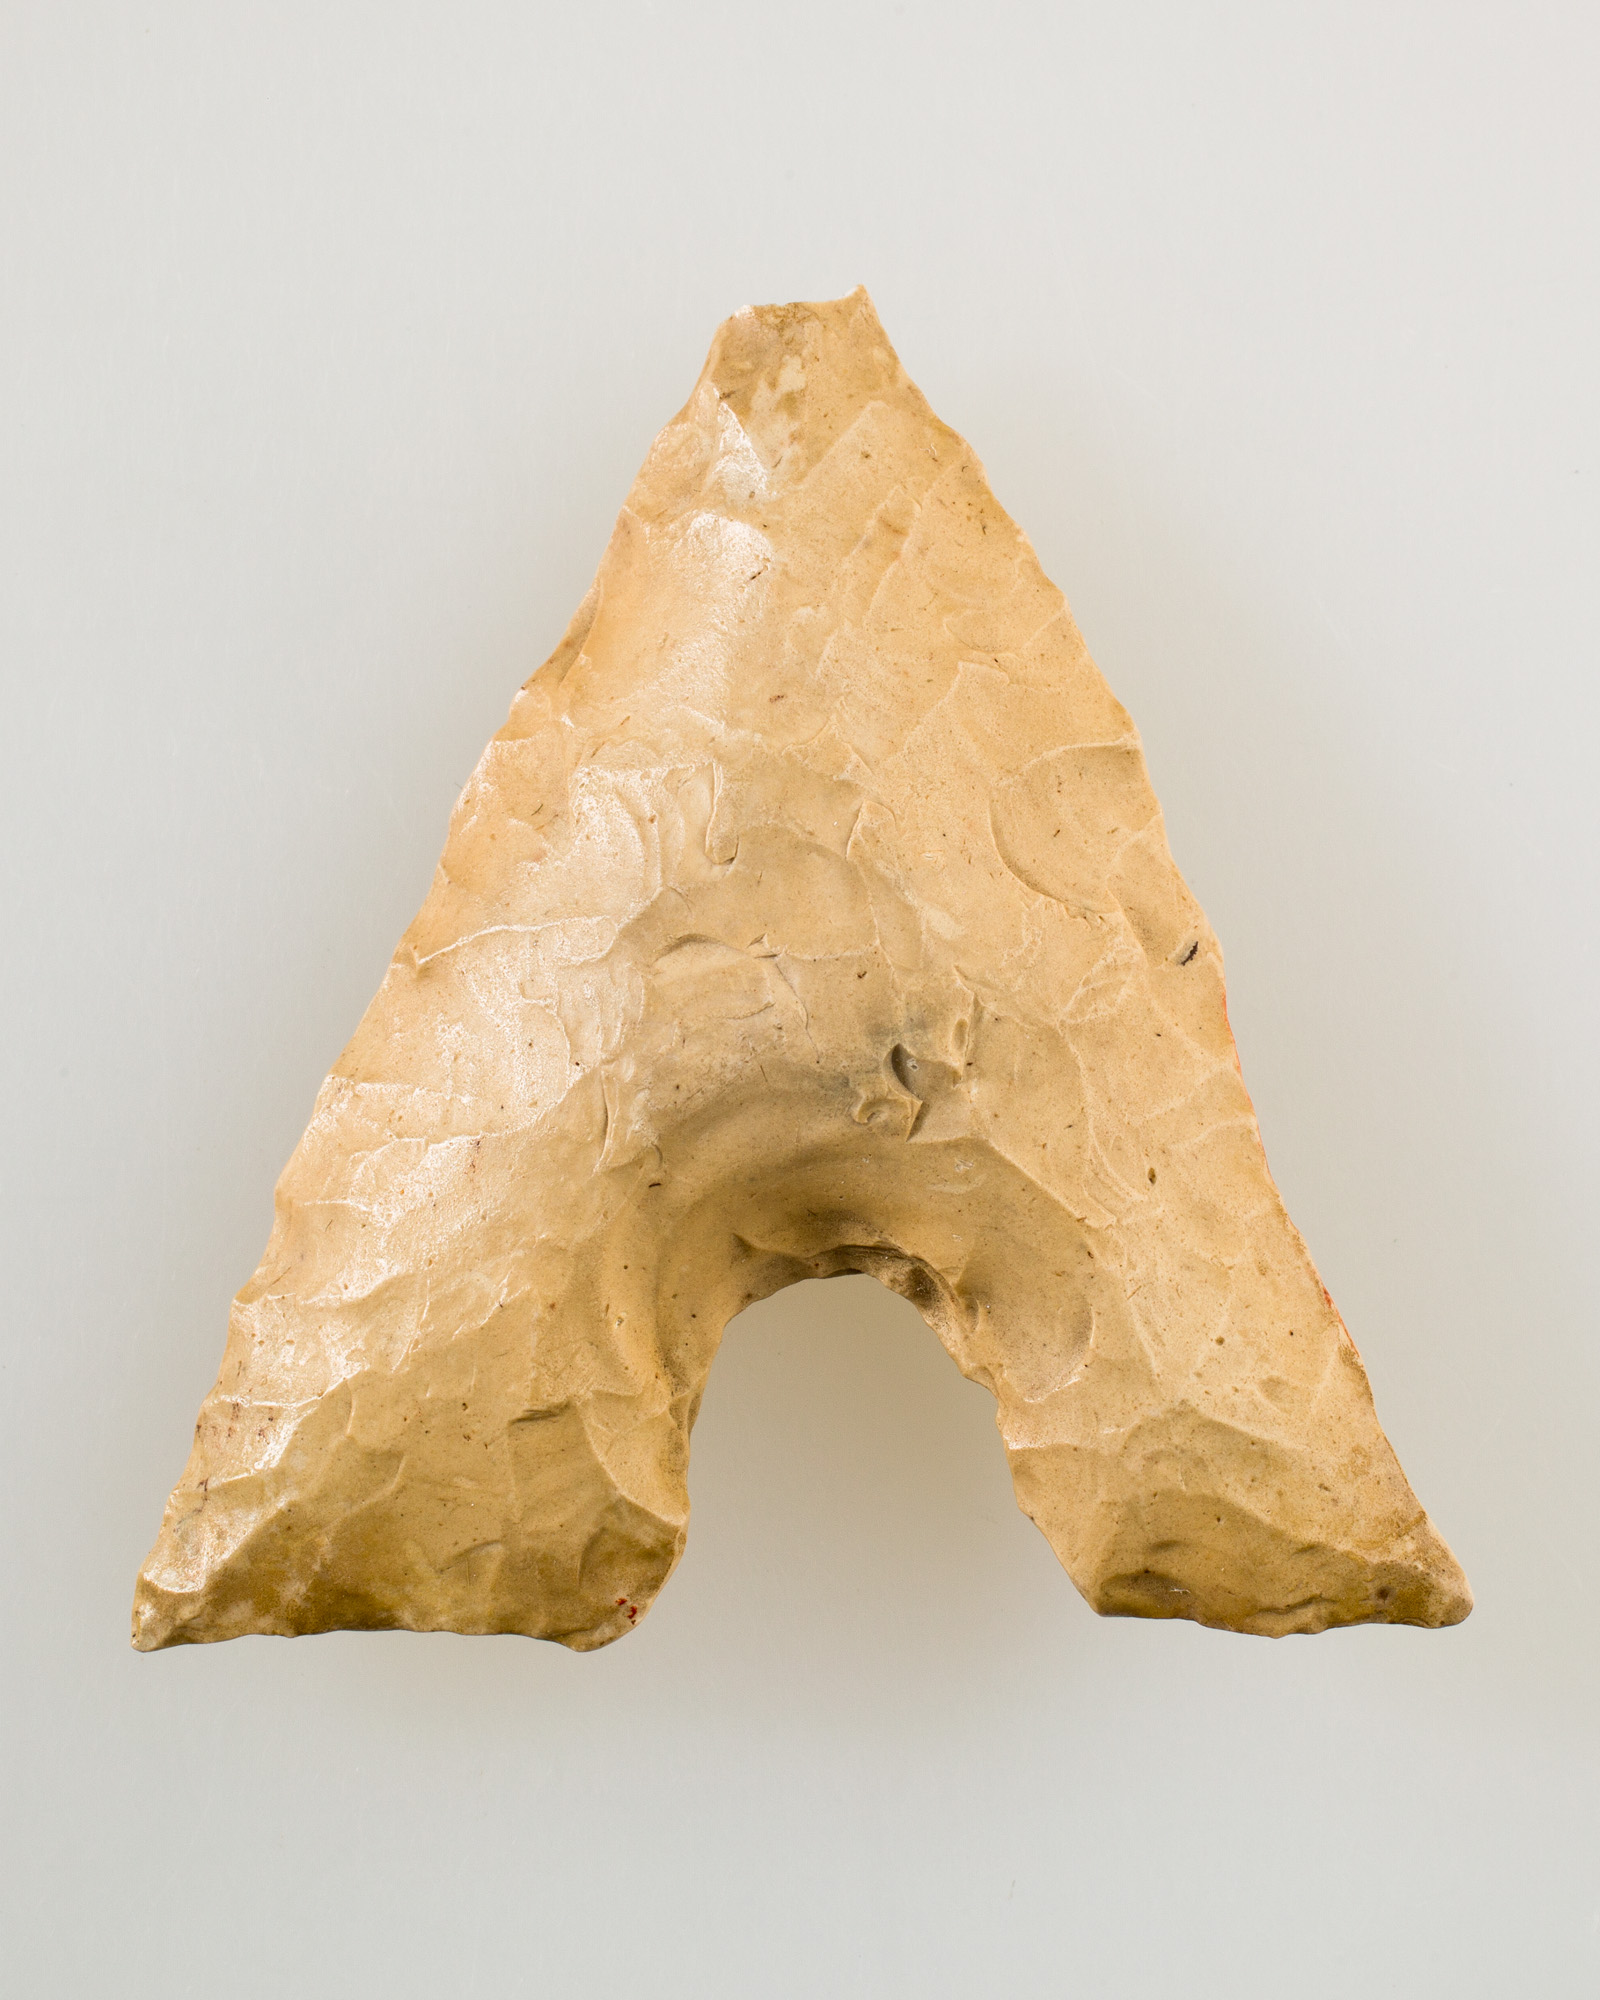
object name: arrowhead, projectile point, hollow base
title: Hollow-Base Projectile Point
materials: stone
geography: egypt